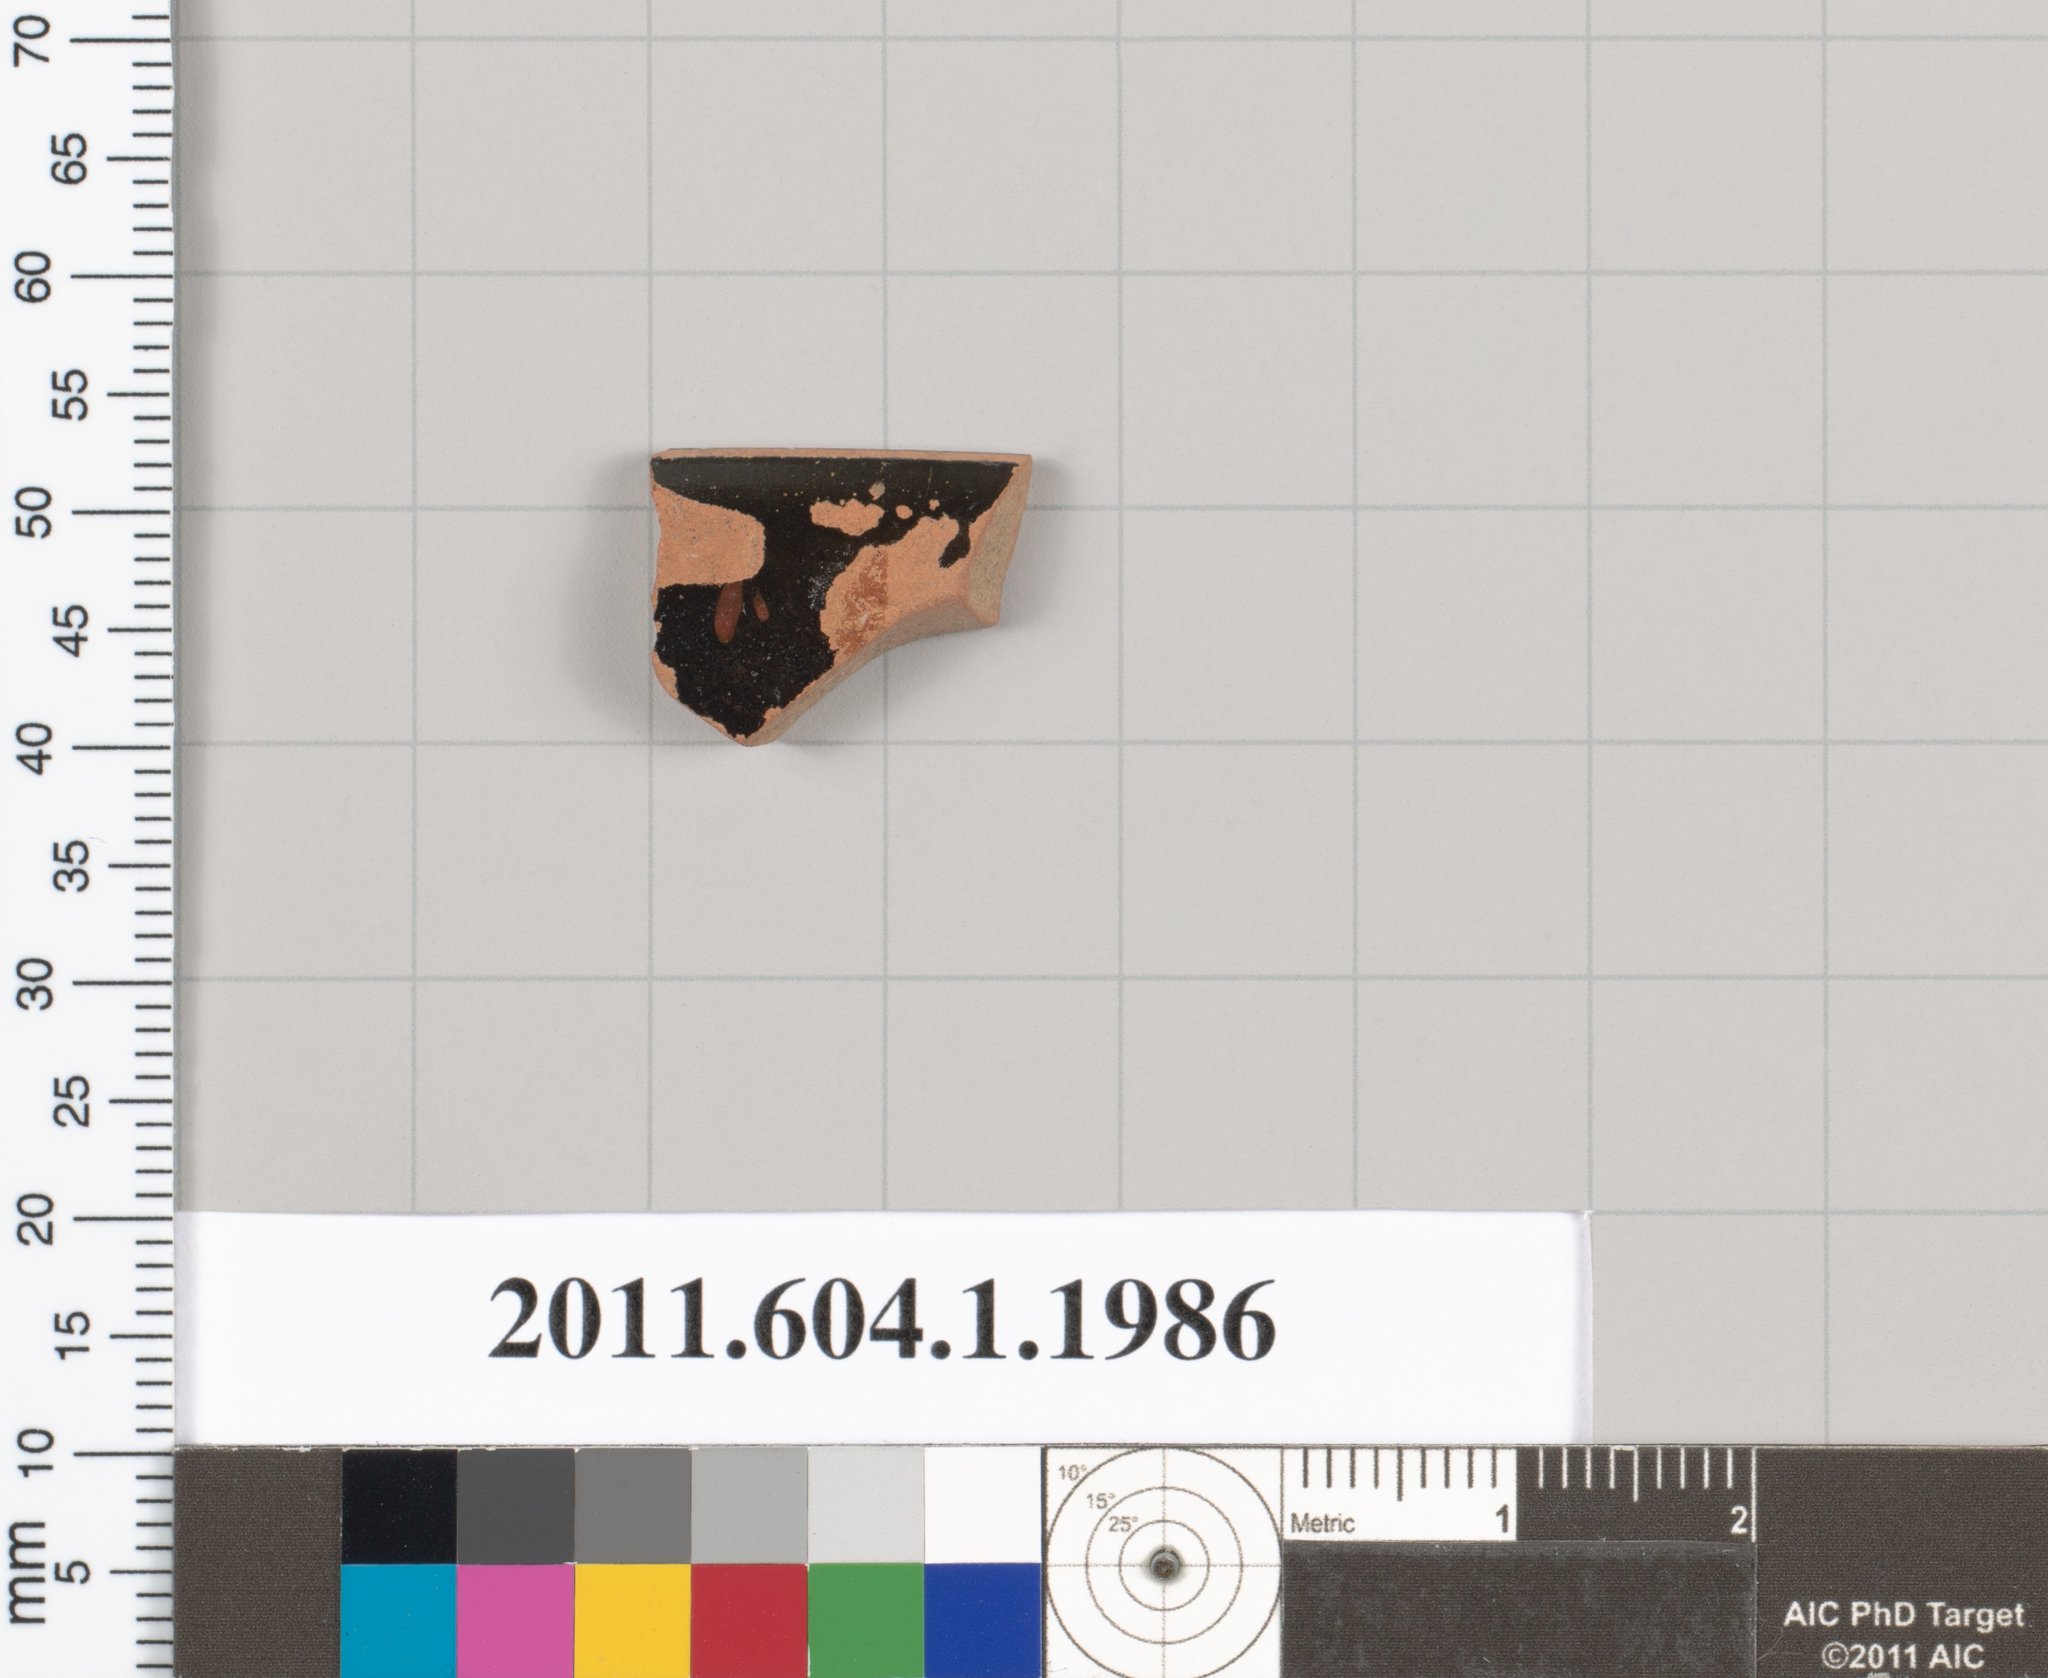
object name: kylix fragment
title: Terracotta rim fragment of a kylix (drinking cup)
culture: greek, attic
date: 500-401 BCE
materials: terracotta